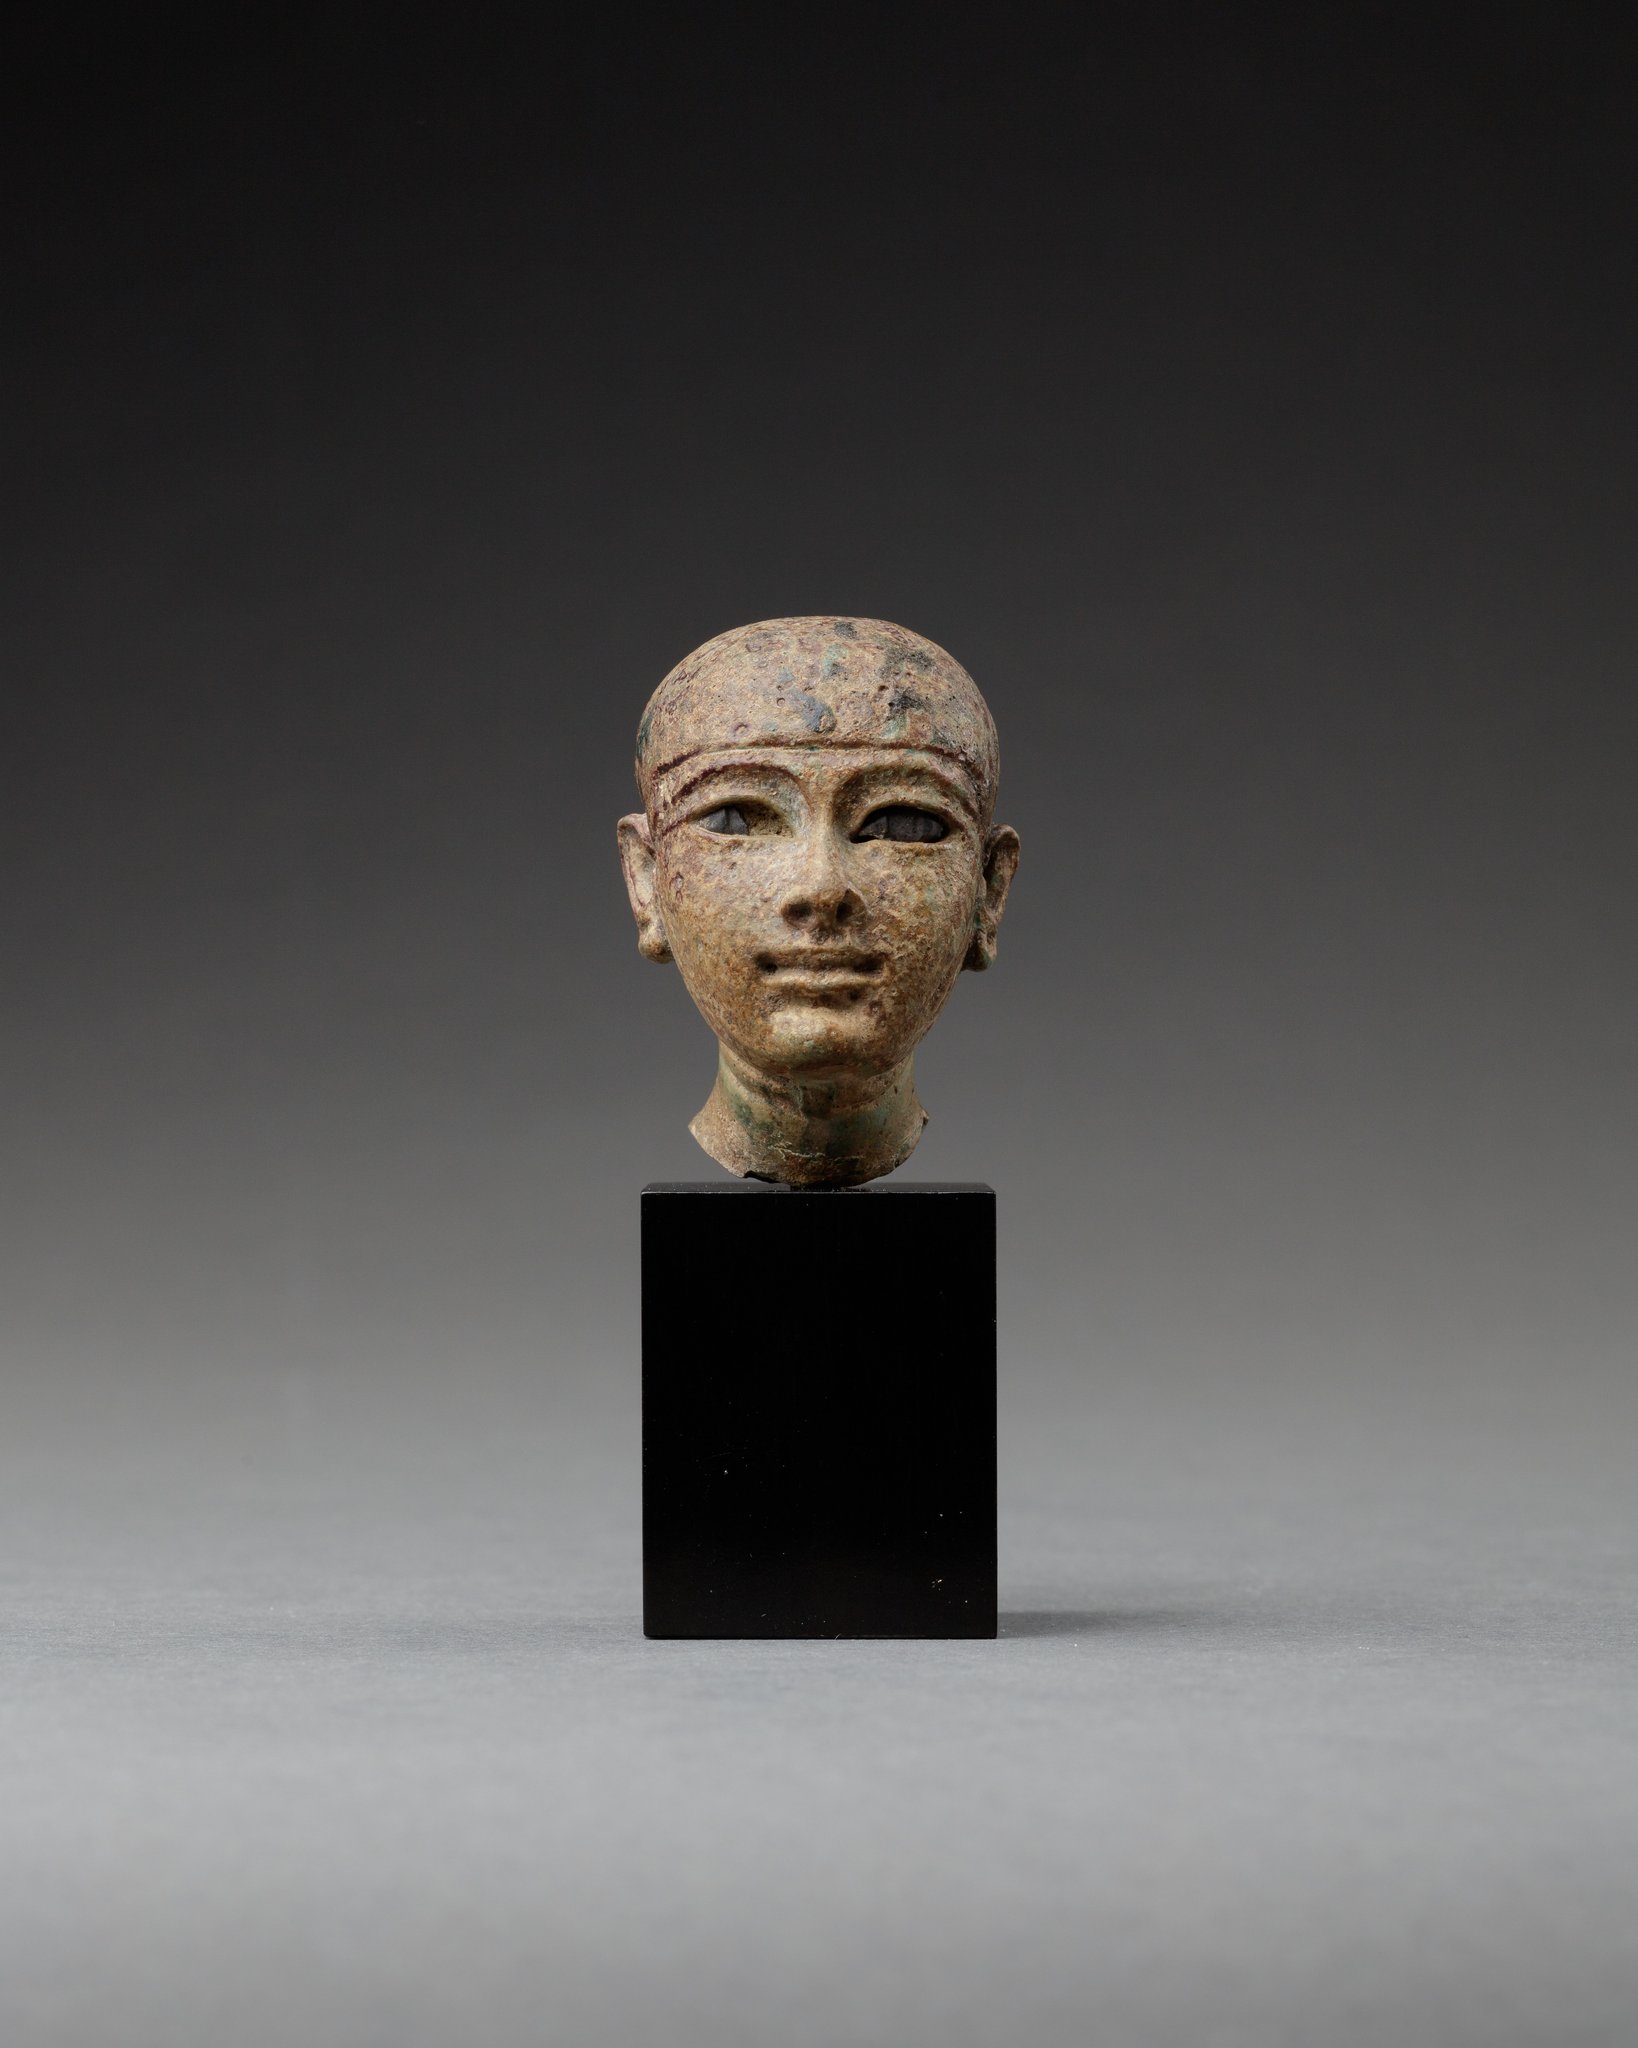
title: Head of a Statuette of Ptah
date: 1550-1070 BCE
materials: faience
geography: egypt